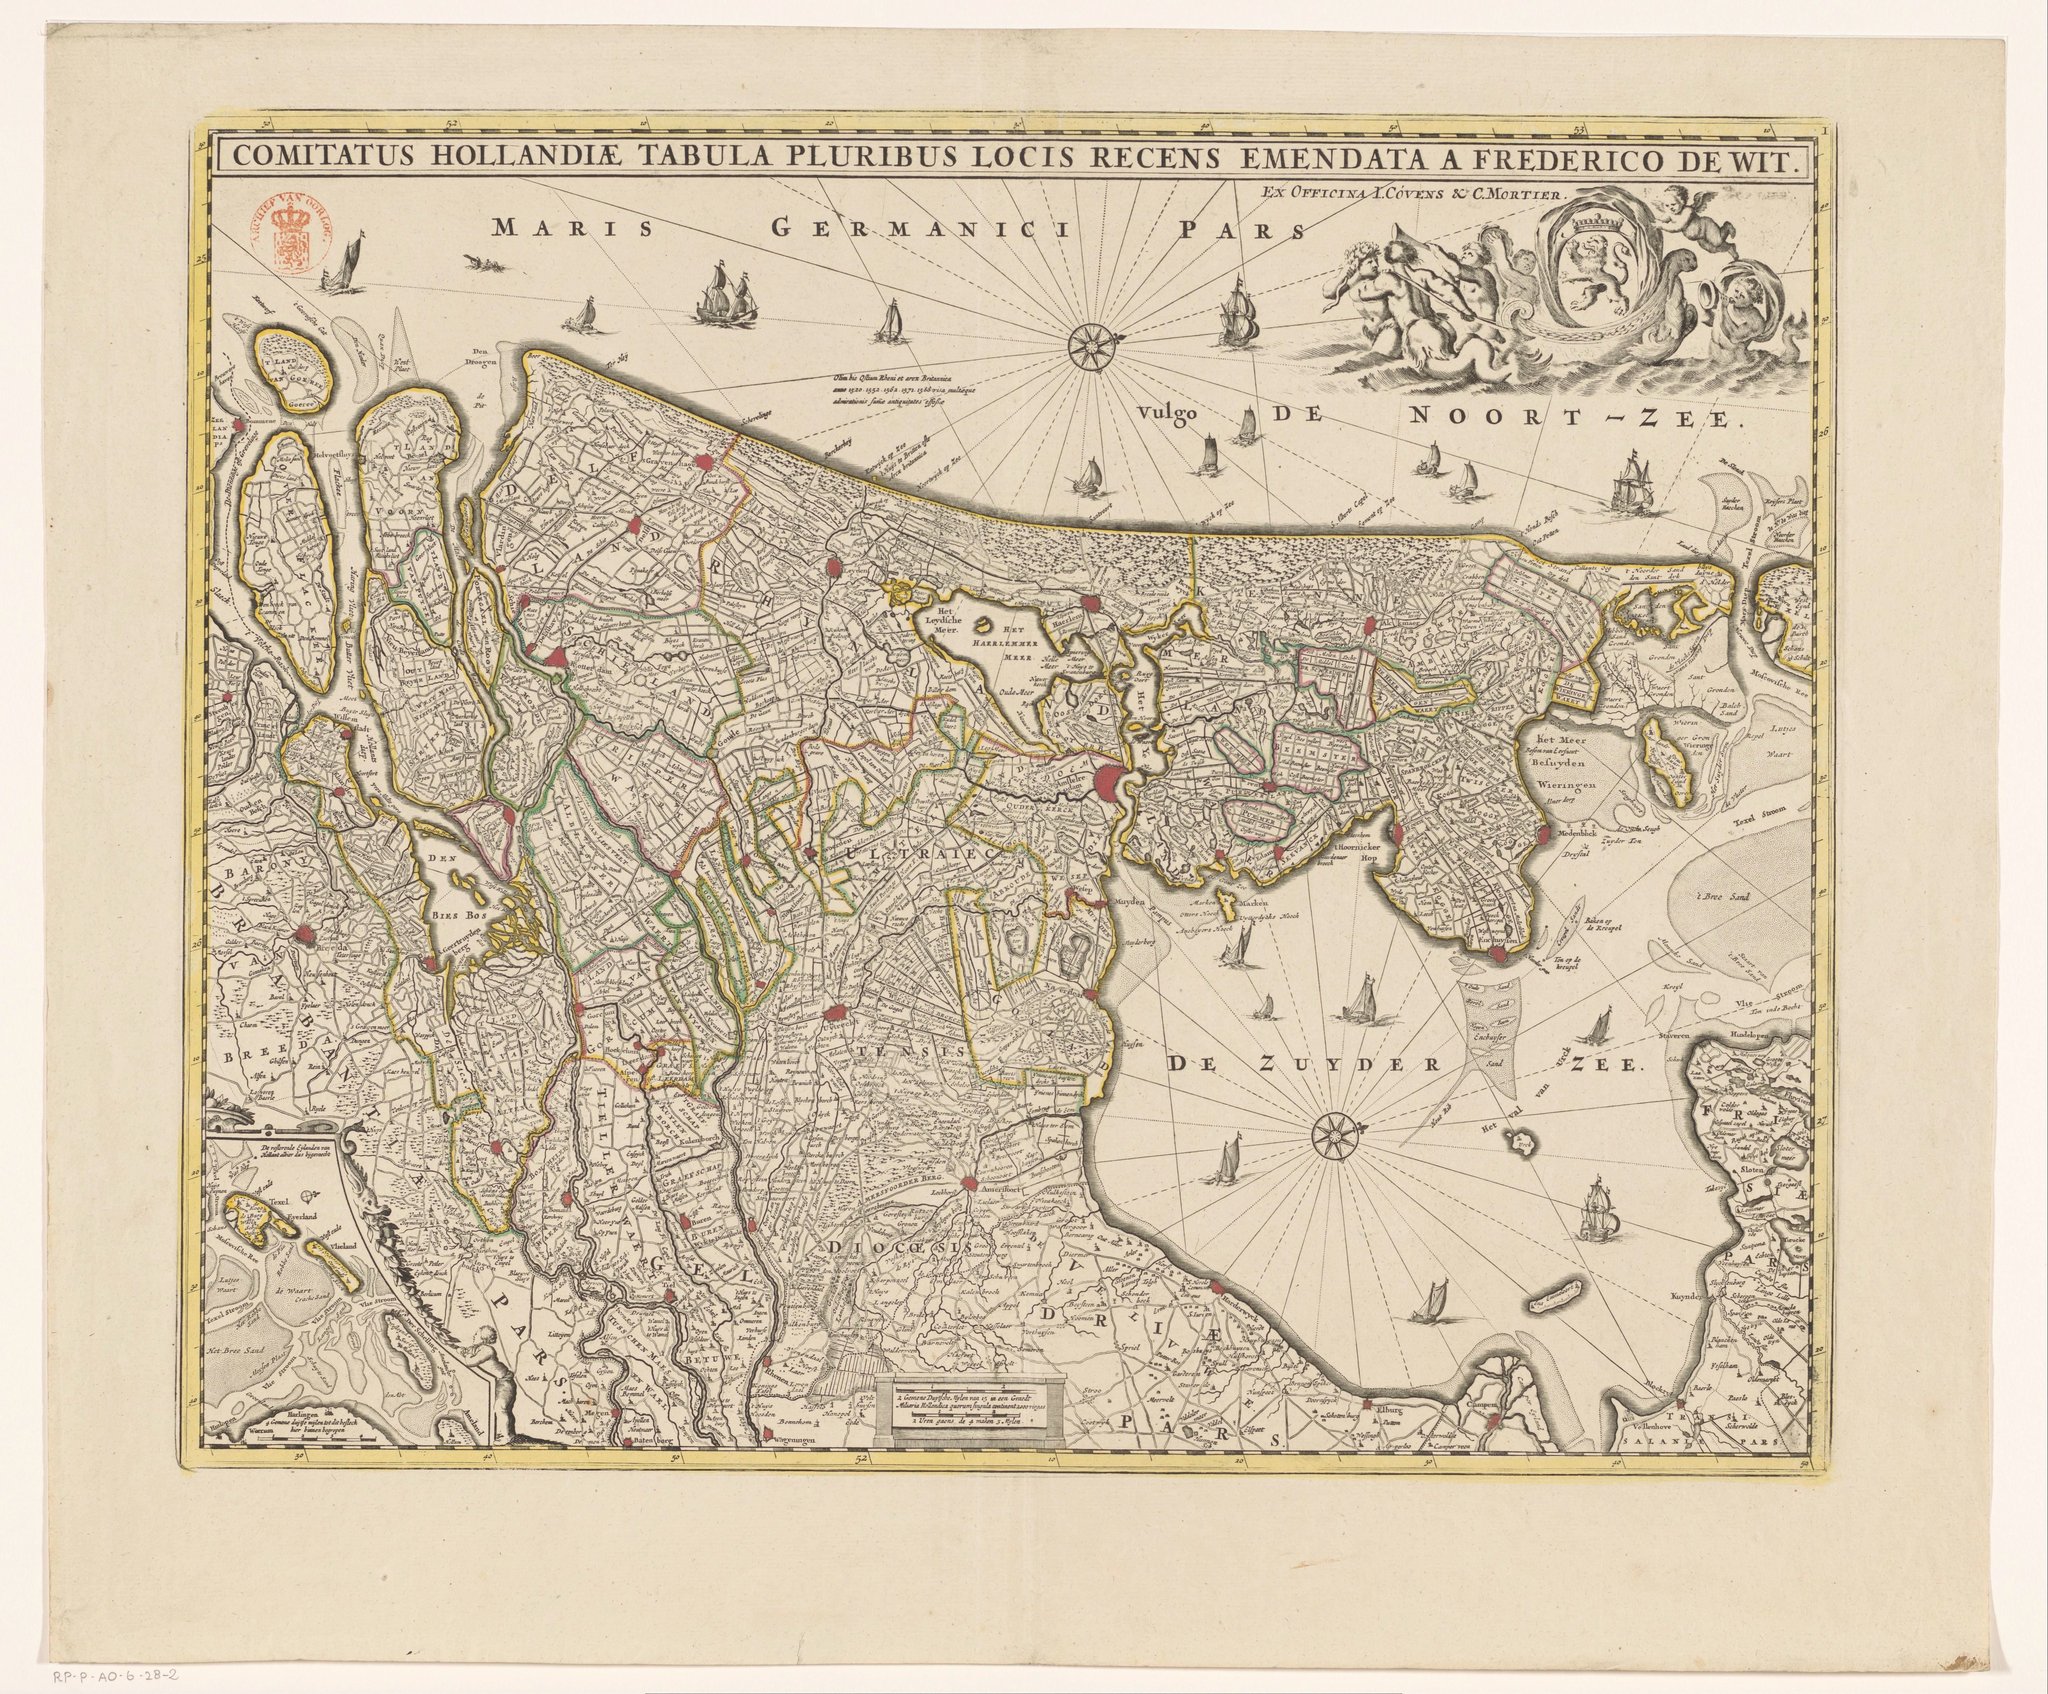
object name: map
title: Kaart van het graafschap Holland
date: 1721-1774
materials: paper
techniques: engraving, hand coloring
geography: amsterdam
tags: coat of arms (as symbol of the state, etc.), triton(s), maps of separate countries or regions, holland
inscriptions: collector's mark: Lugt 19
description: Kaart van het graafschap Holland en omliggende gebieden. Linksonder een inzetkaartje van het Waddengebied met een schaalstok: 4 gemene duijtse tot dit besteck hier binnen begrepen. Onder in het midden twee schaalstokken voor de kaart zelf: 2 gemene Duytsche mylen van 15 in een graedt / Miliaria Hollandica quorum singula continent 2000 virgas; 2 uren gaens de 4 maken 3 mylen. Rechtsboven het wapen van het graafschap met daaromheen putti en tritons. Gradenverdeling langs de randen. Oriëntatie: noorden rechts.